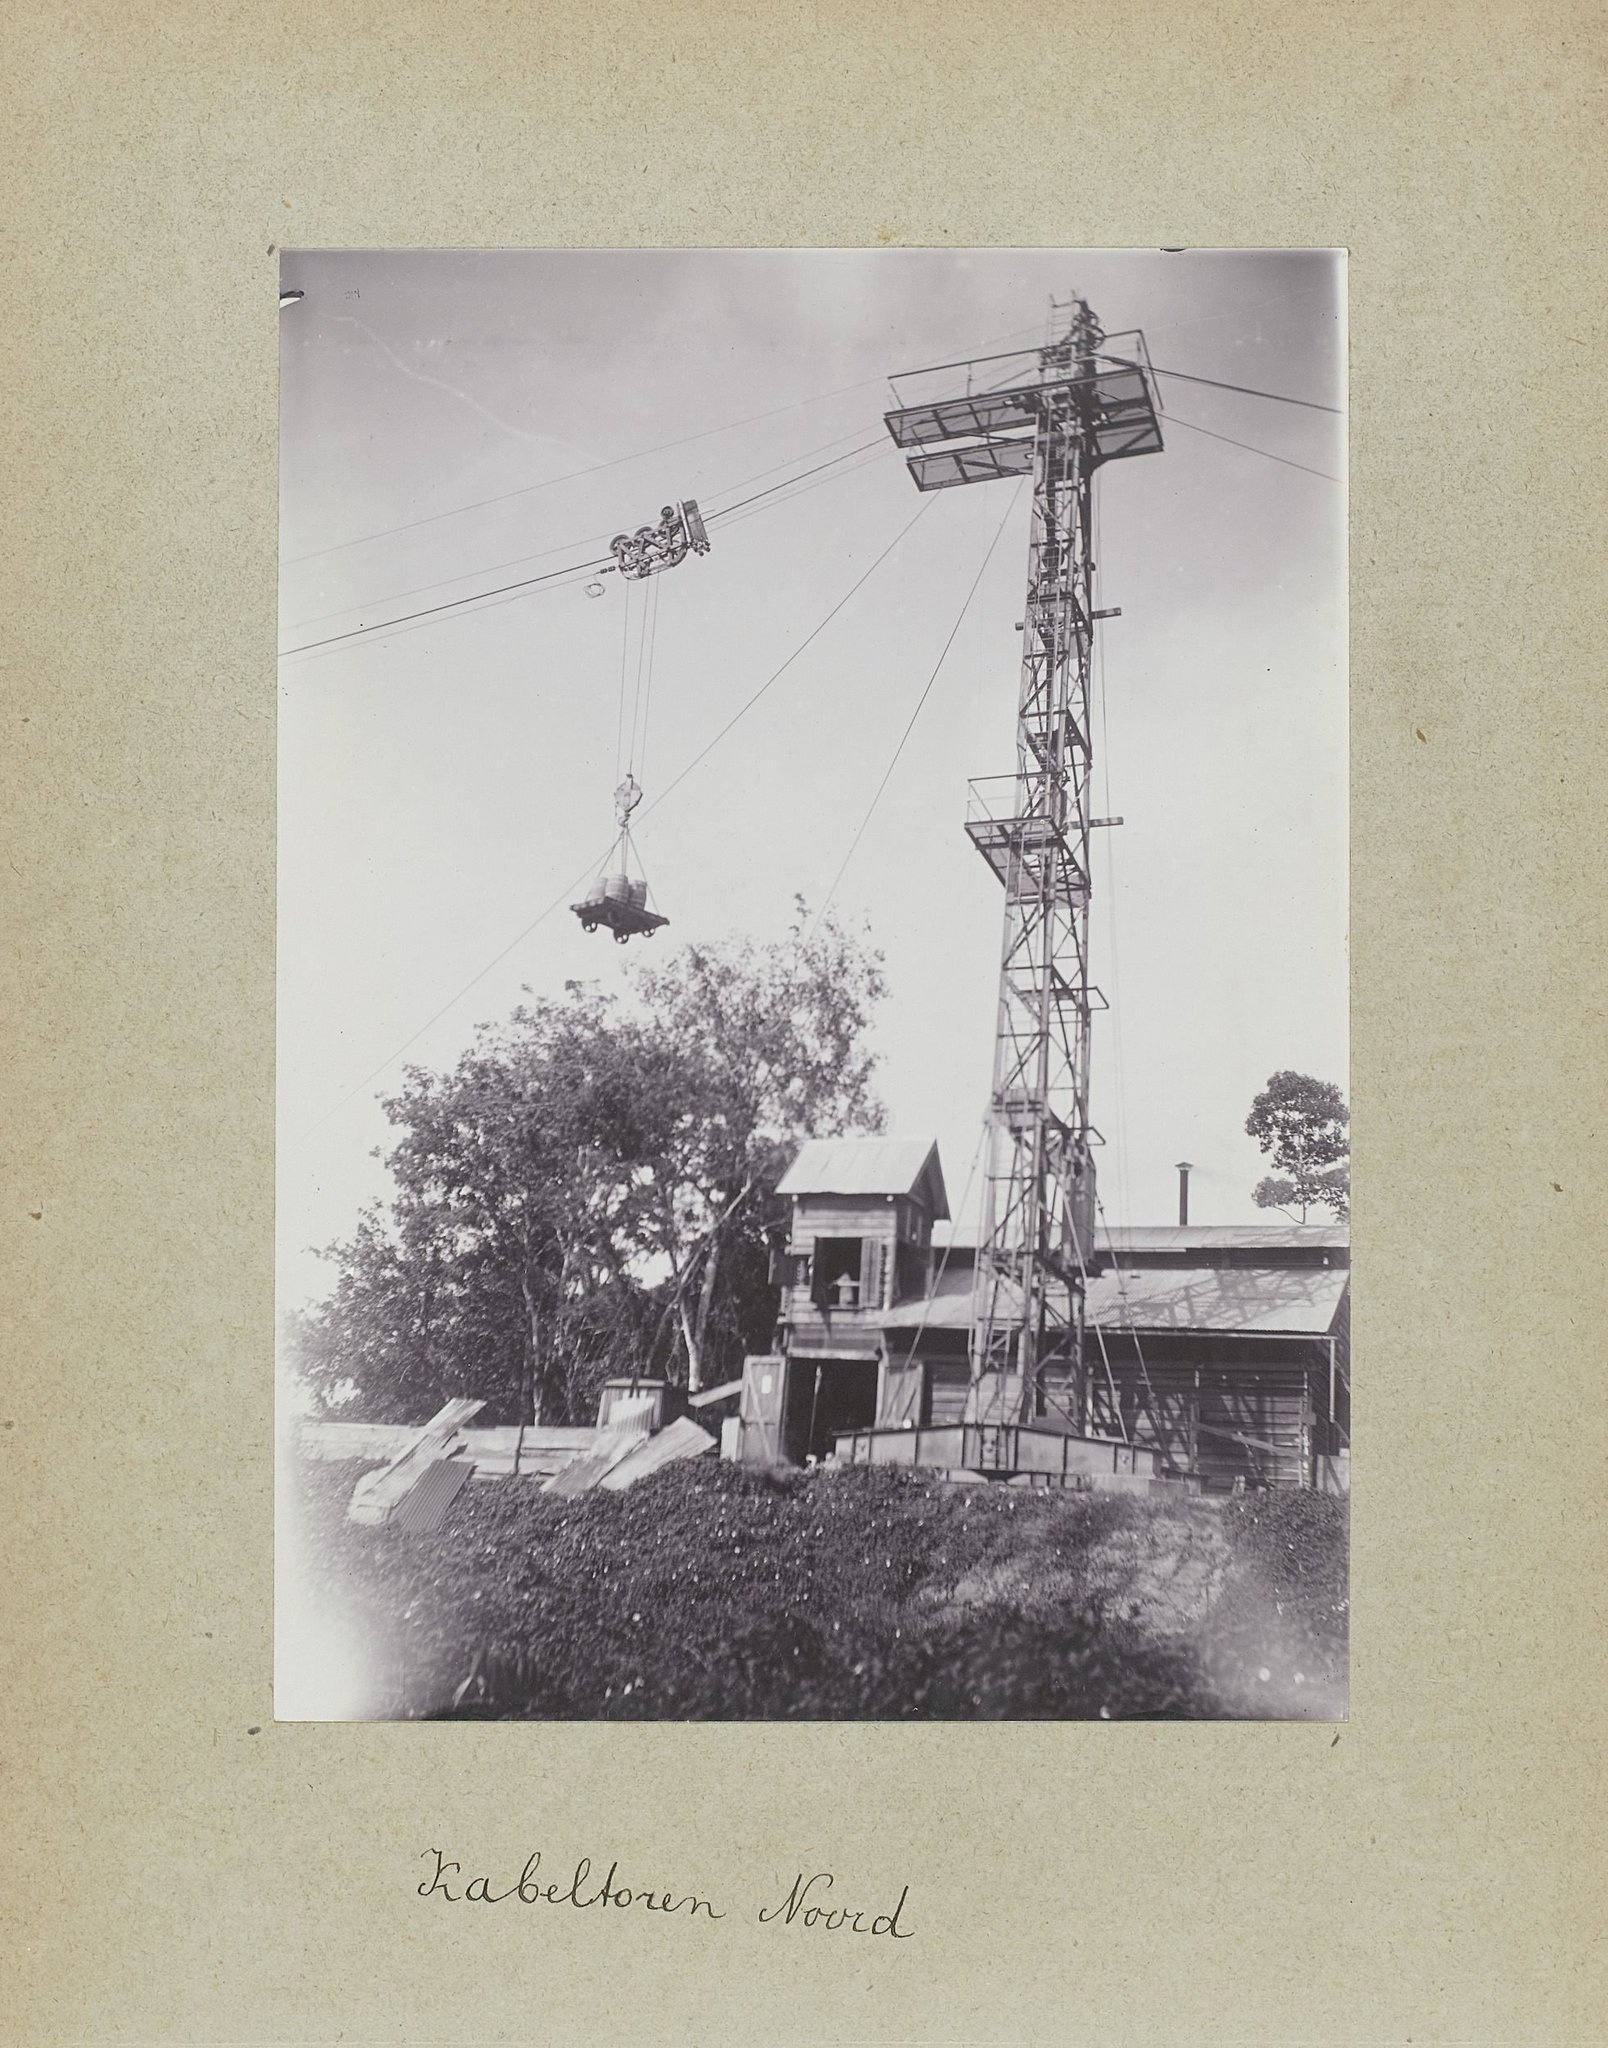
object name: photograph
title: Kabeltoren Noord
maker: Anonymous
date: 1905-1910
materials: photographic support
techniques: photography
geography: suriname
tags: jacob evert wesenhagen, railway, tramway; rack railway, suriname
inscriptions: inscription: ‘Kabeltoren Noord’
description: De kabeltoren aan de noordzijde van de Surinamerivier. Foto in het fotoalbum over de aanleg van de Lawaspoorweg in Suriname in de jaren 1903-1912. Onderdeel van een groep objecten afkomstig van de familie Wesenhagen in Suriname.